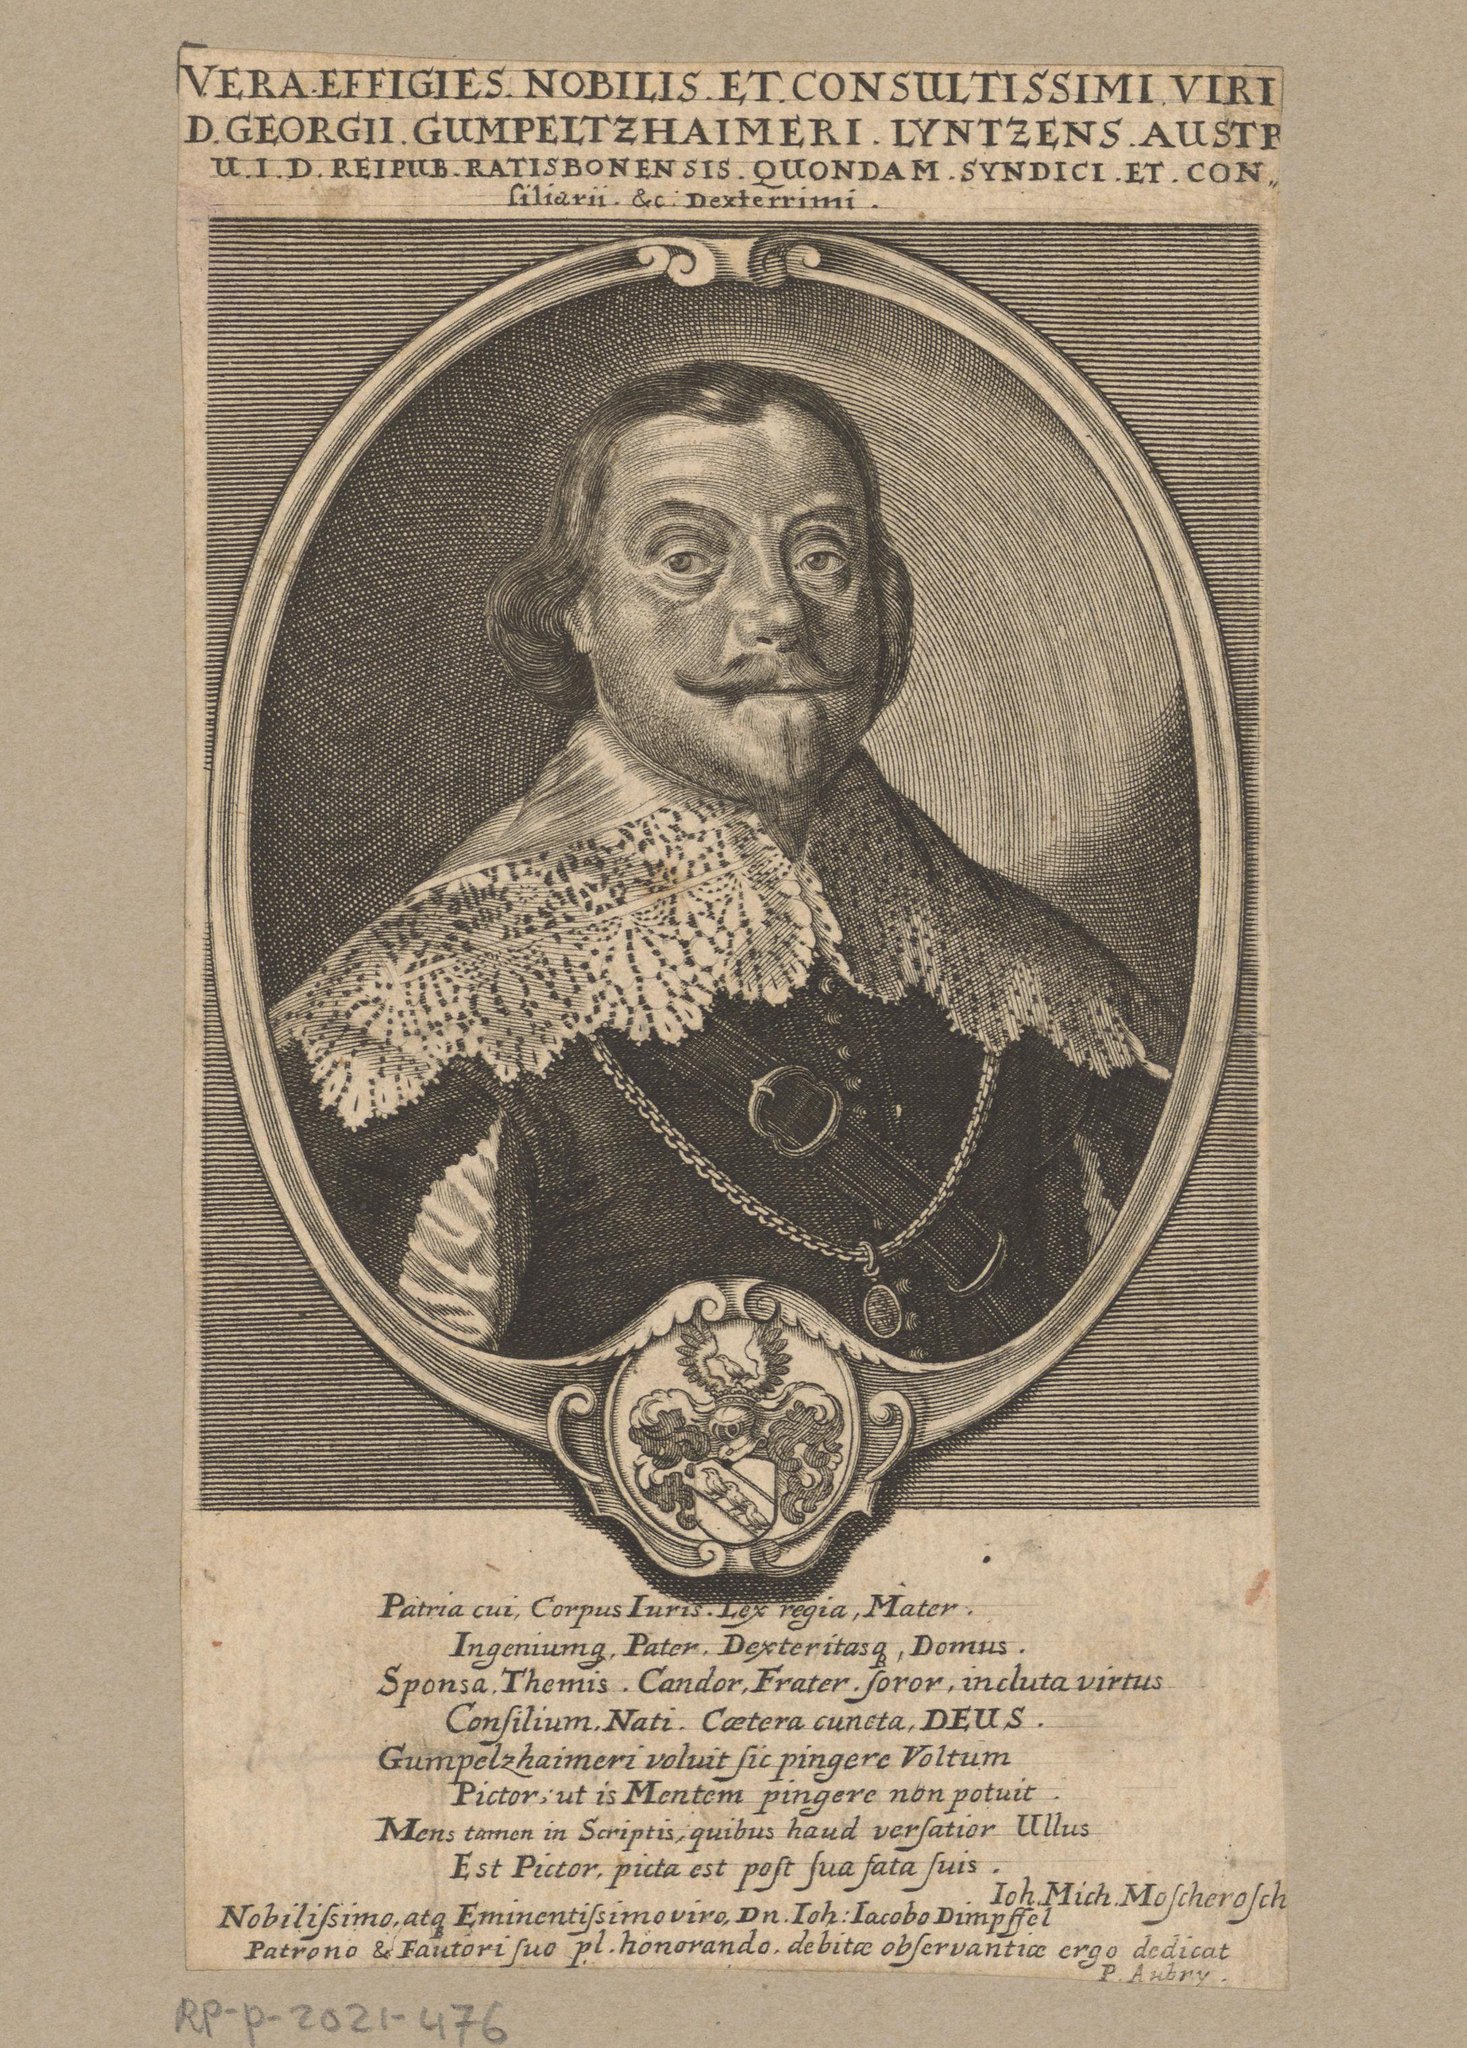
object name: print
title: Portret van Georg Gumpelzhaimer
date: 1620-1672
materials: paper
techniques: engraving, etching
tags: historical persons